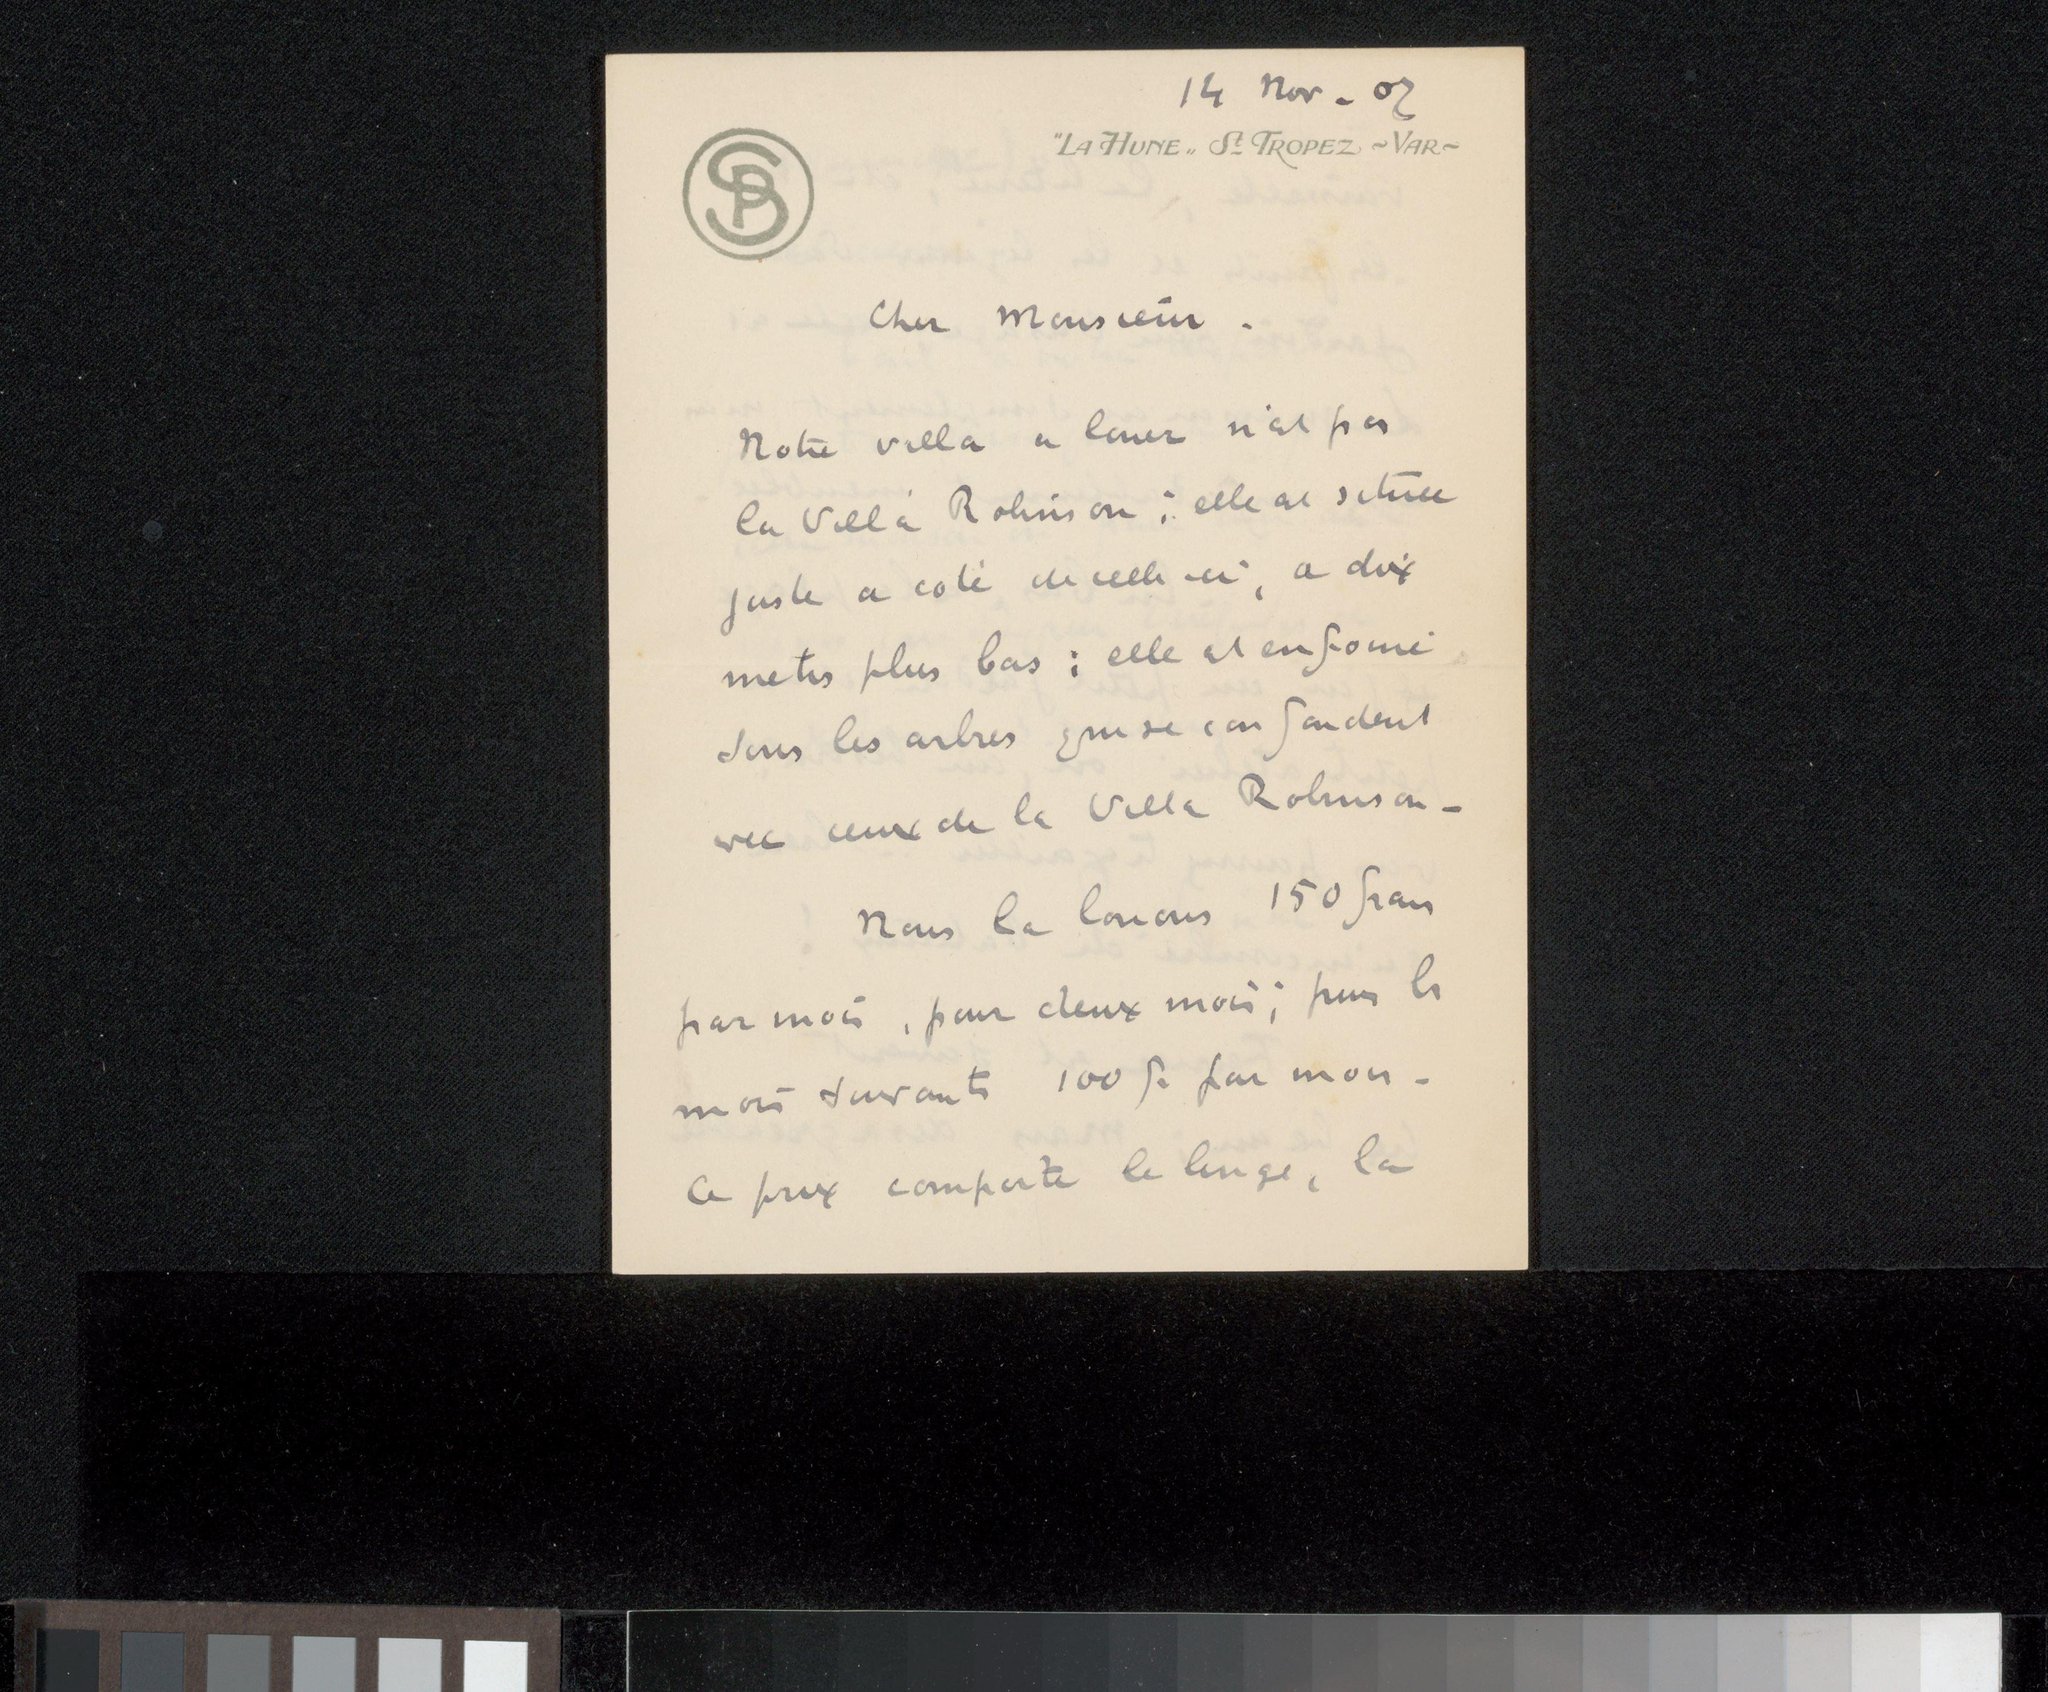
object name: letter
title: Brief aan Philip Zilcken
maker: paul signac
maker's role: print maker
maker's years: 1863-1935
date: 1907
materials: ink, paper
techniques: pen, printing, writing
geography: saint-tropez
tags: painter, draughtsman, philip zilcken, workshop, studio of the artist (in general), money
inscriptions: monogram: ‘PS’, watermark, collector's mark: ‘RPK’